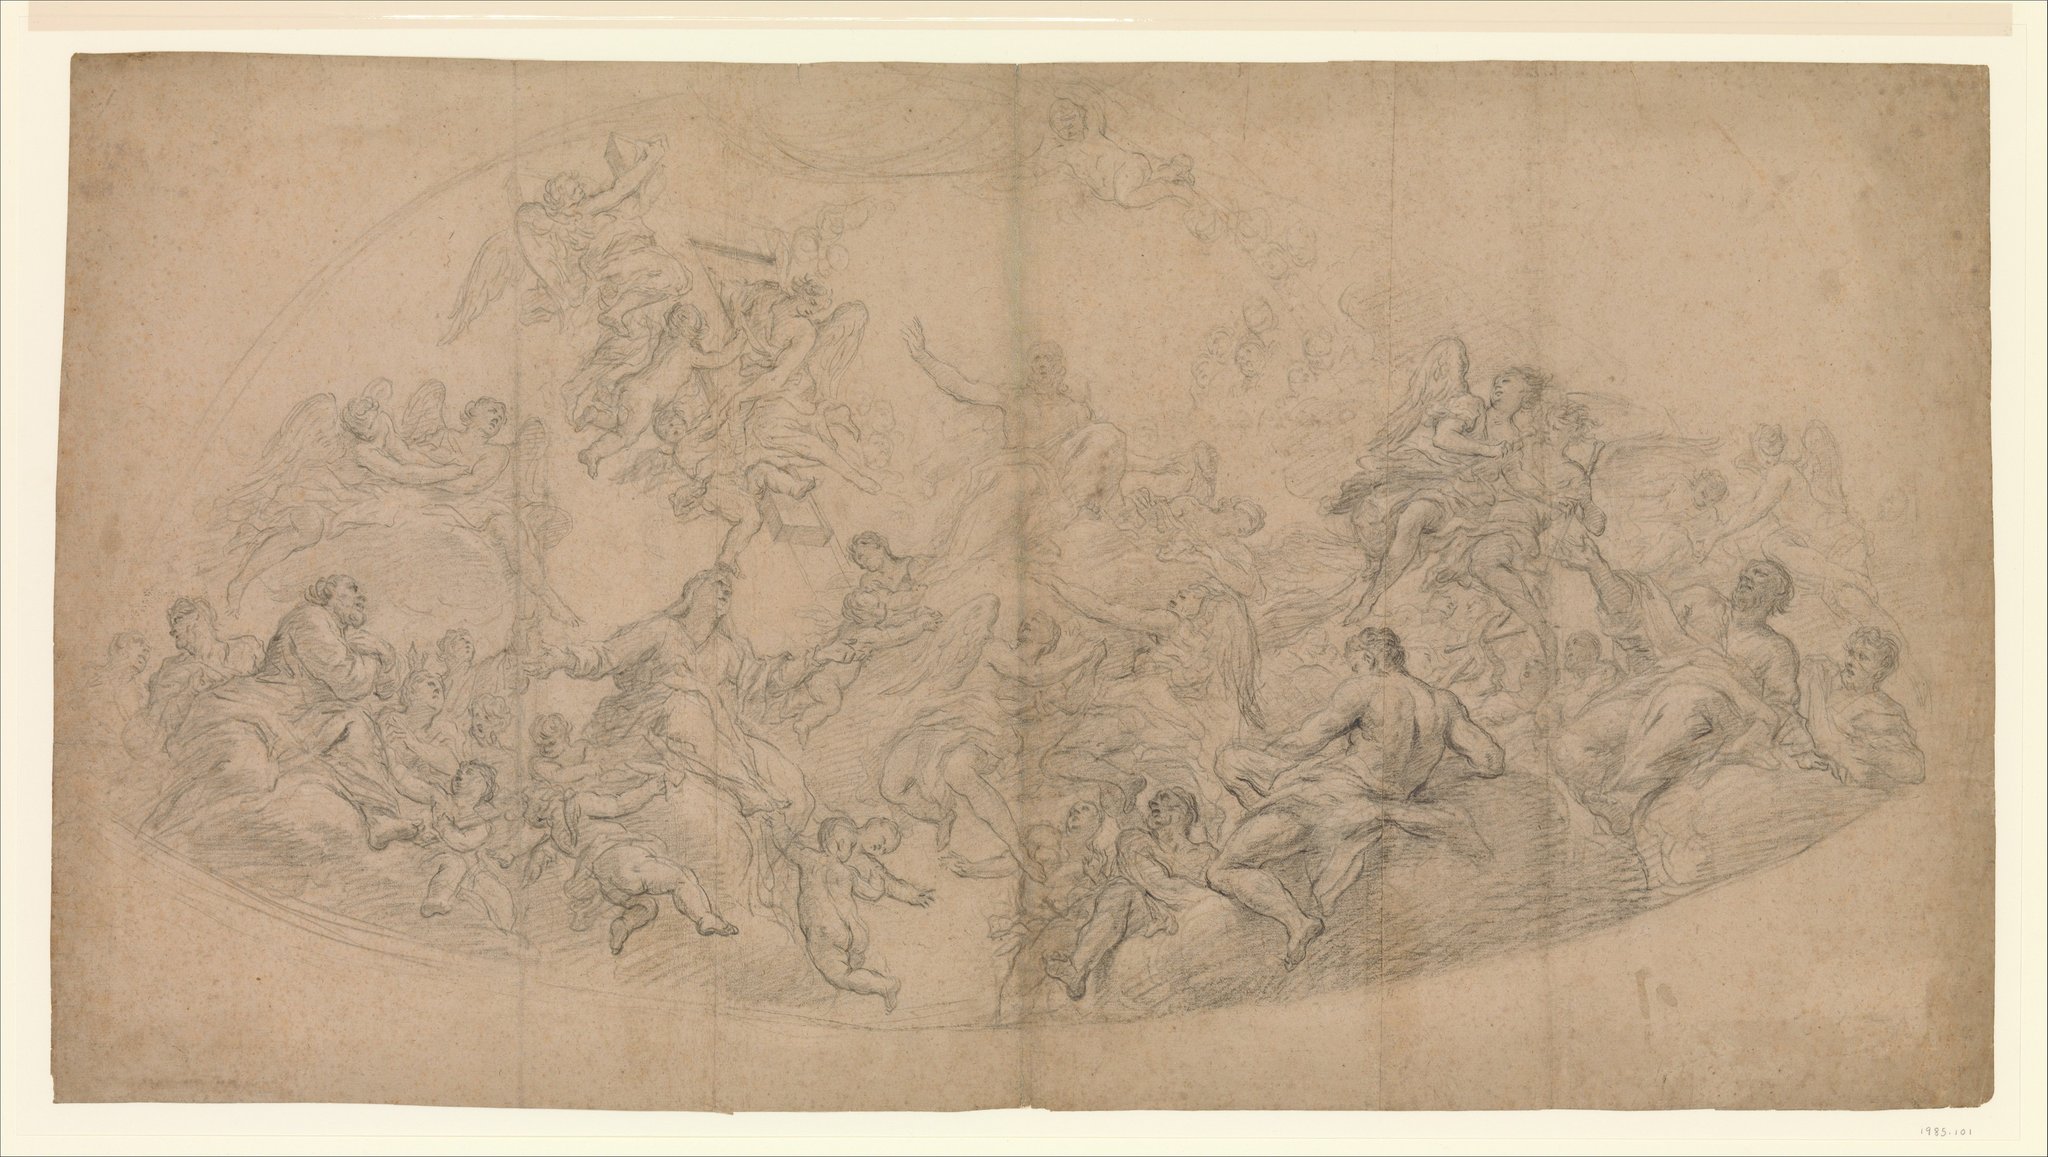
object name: drawing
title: Exaltation of the Holy Cross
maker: antonio puglieschi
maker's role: artist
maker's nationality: italian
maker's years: 1660-1732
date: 1700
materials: charcoal, paper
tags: putti,angels,christ,virgin mary,saints